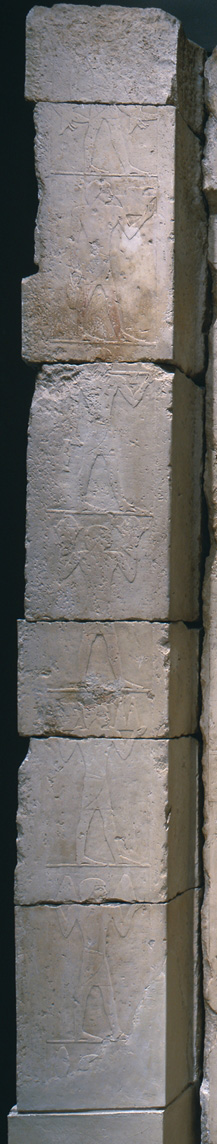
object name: relief, tomb chapel, raemkai, offering bearer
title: Tomb chapel of Raemkai: west wall, offering bearers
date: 2446-2389 BCE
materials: limestone, paint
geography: egypt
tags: men